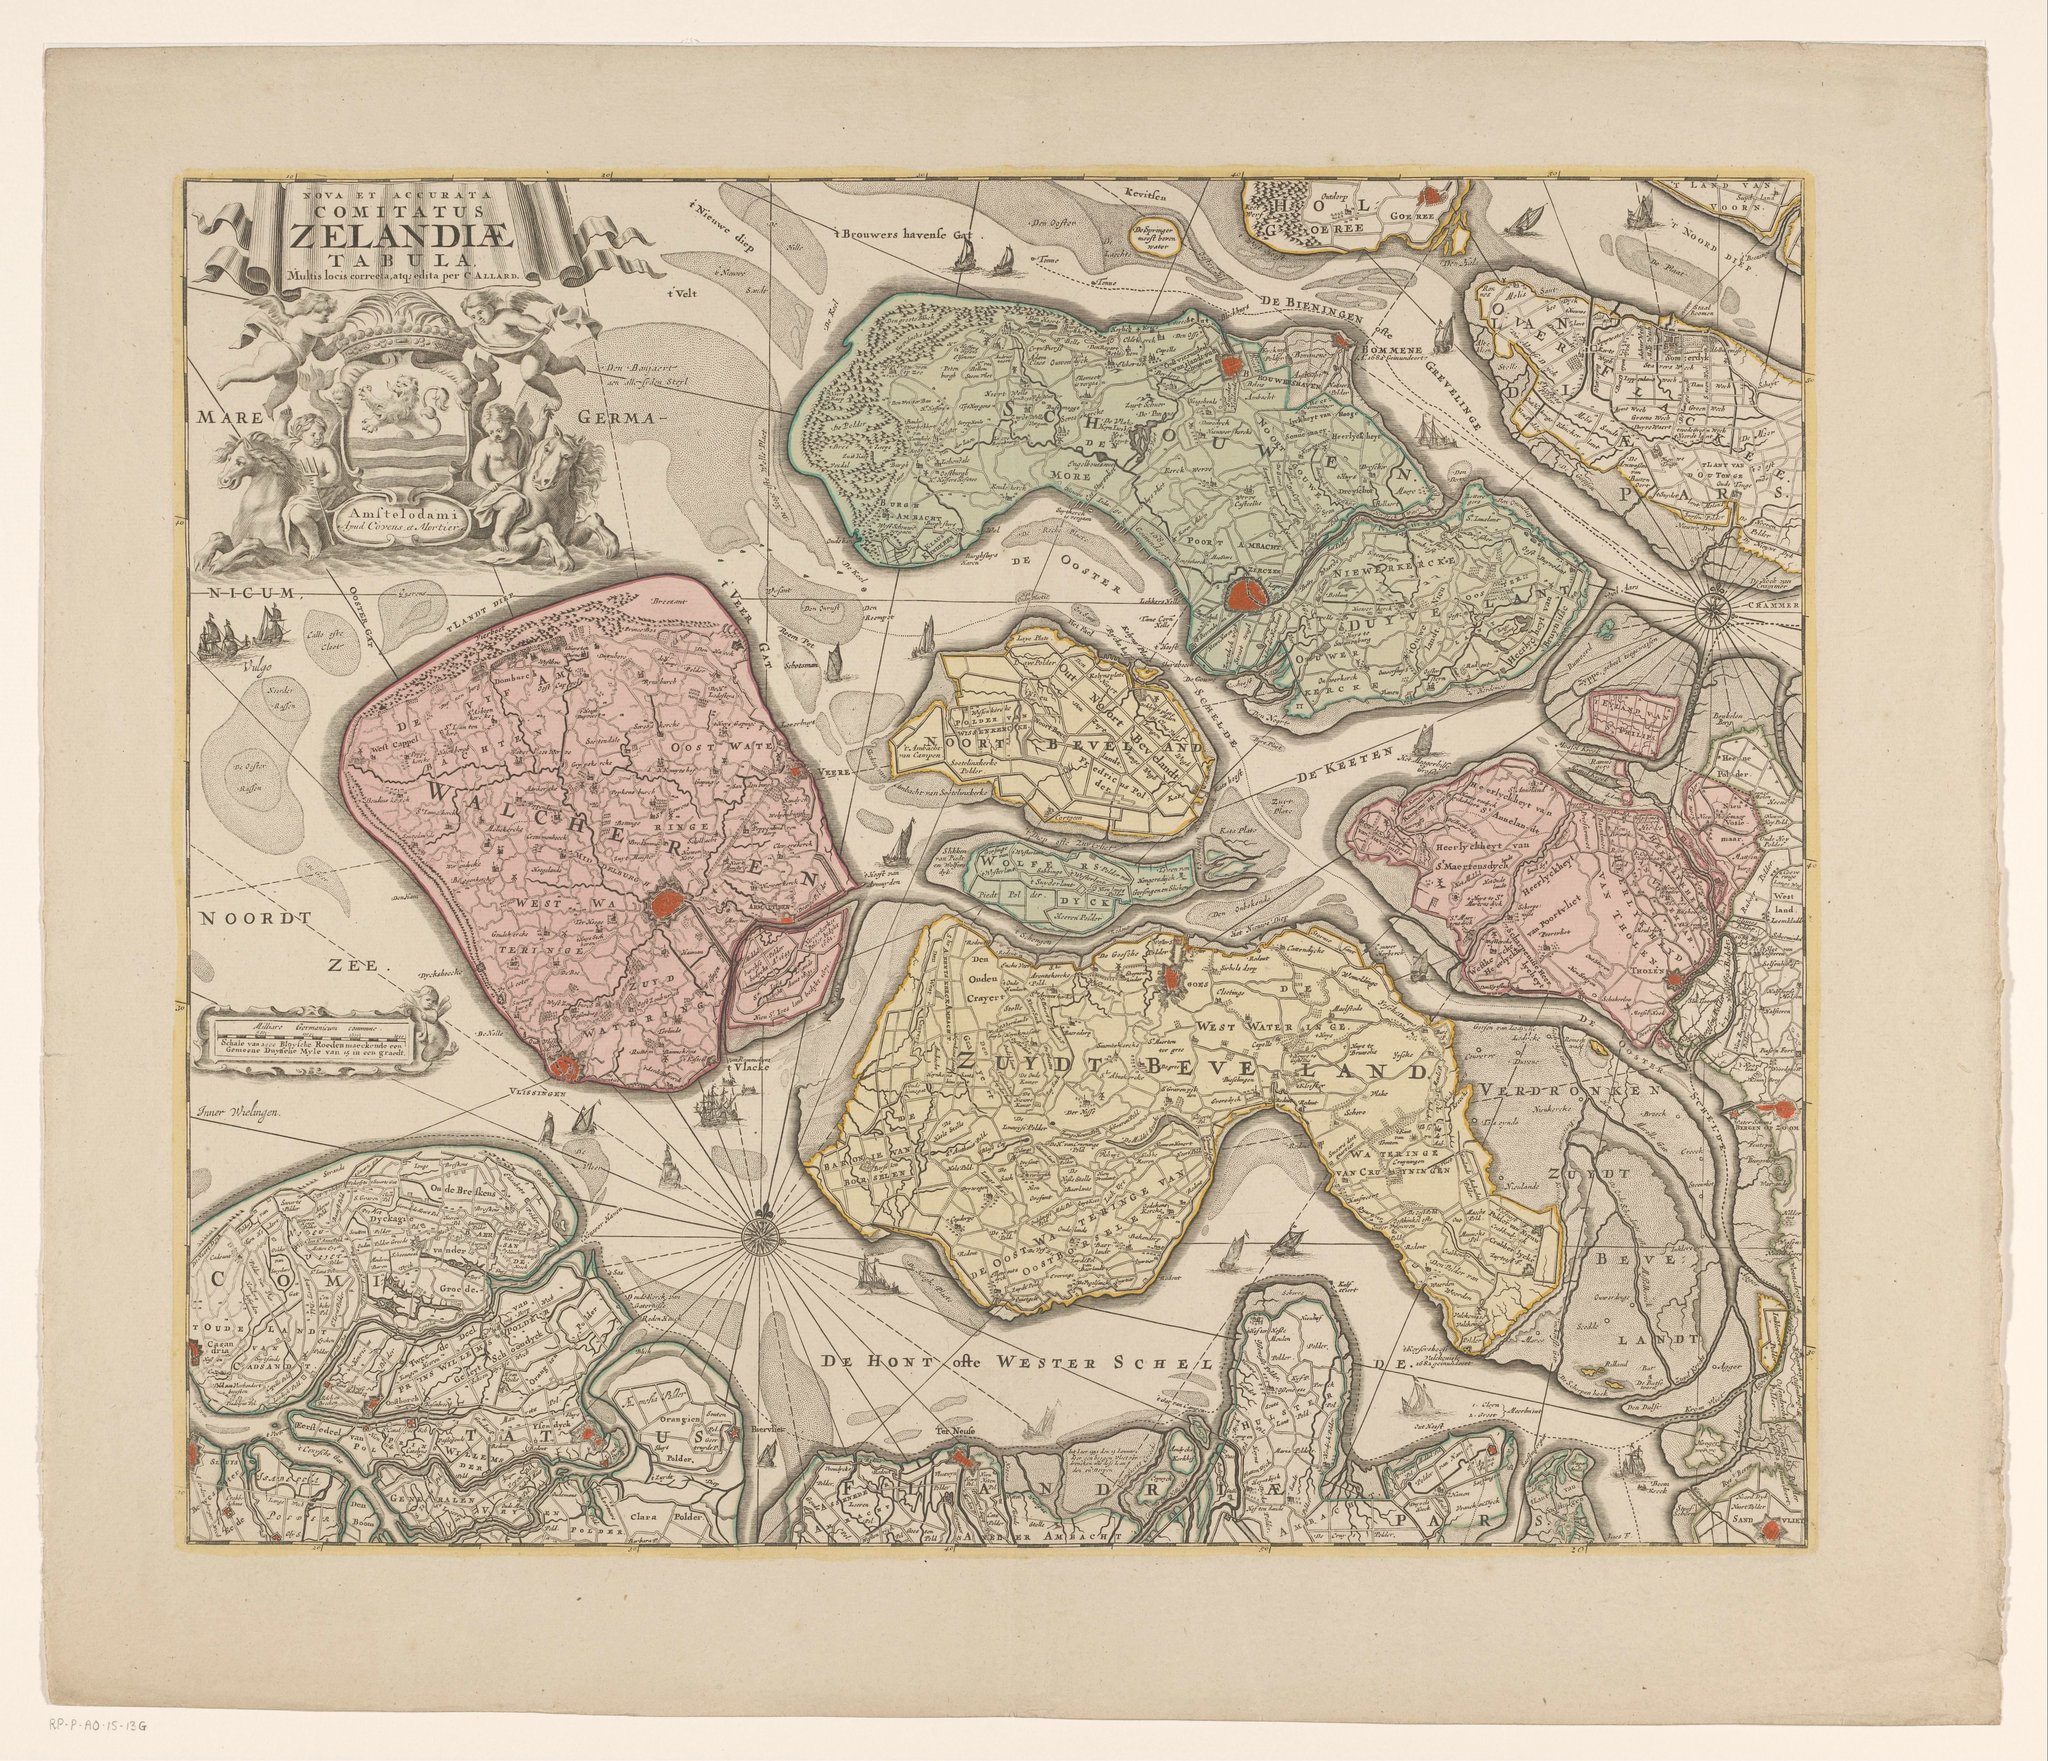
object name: map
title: Kaart van Zeeland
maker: Anonymous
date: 1674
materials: paper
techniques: engraving, etching, hand coloring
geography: amsterdam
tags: maps of separate countries or regions, coat of arms (as symbol of the state, etc.) (+ province; provincial), zeeland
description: Linksboven de titel met daaronder het wapen van Zeeland. Links onder het midden een schaalstok: Milliare Germanicum commune / Schale van 2000 Bloysche roeden maeckende een gemeene Duytsche myle van 15 in een graedt. Gradenverdeling langs de randen.